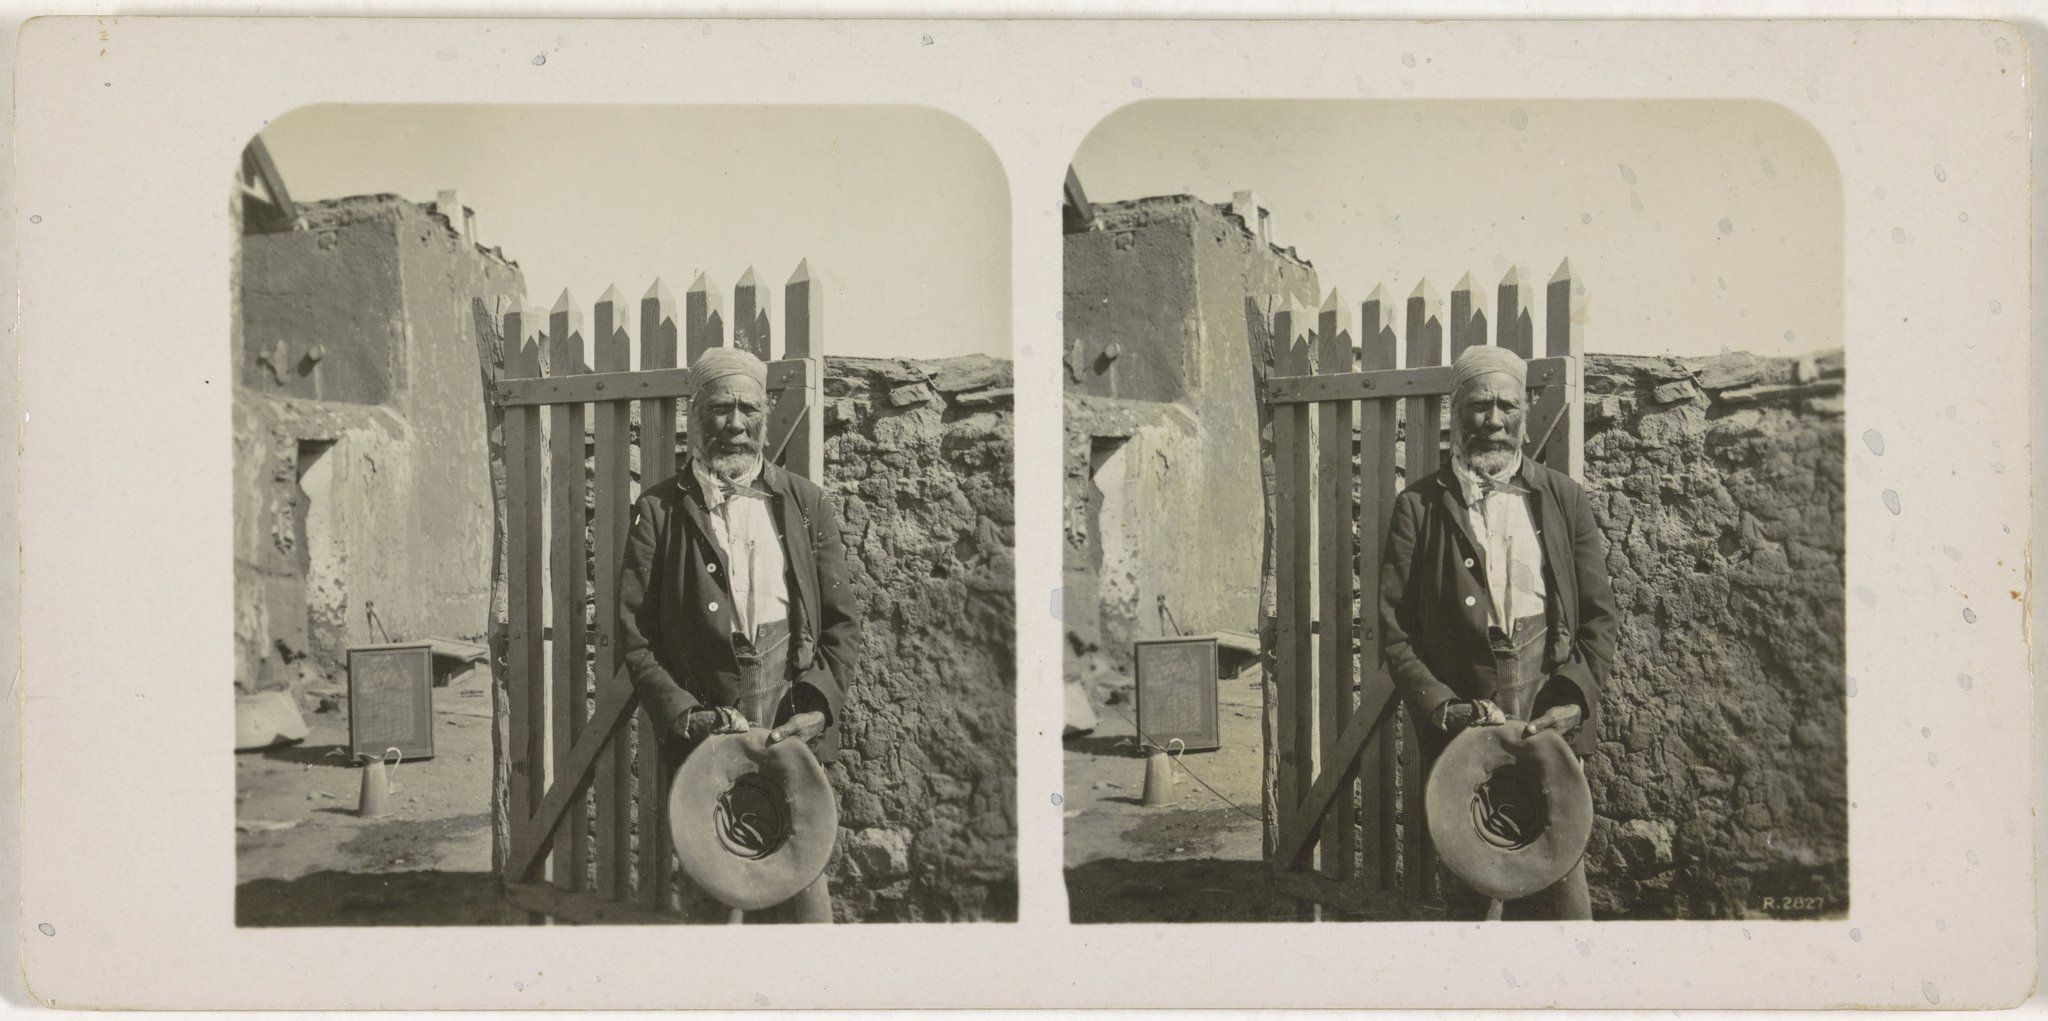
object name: stereograph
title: Portret van Ari Swart te Rehoboth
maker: Anonymous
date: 1884-1914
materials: cardboard, paper, photographic support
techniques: gelatin silver print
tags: historical persons, head-gear: hat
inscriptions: title: ‘Süd-West-Afrika / 2827. / Der Bastard Swart Ari in Rehobot / The bastard Swart Ari in Rehobot / Le bâtard Swart Ari à Rehobot / En bastardo Swart Ari a Rehobot’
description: De Baster gemeenschap waartoe Ari Swart behoorde bestond uit afstammelingen van Nederlanders uit de Kaapkolonie en Khoisan. Rond 1870 vestigden zij zich in Rehoboth, het huidige Namibië.